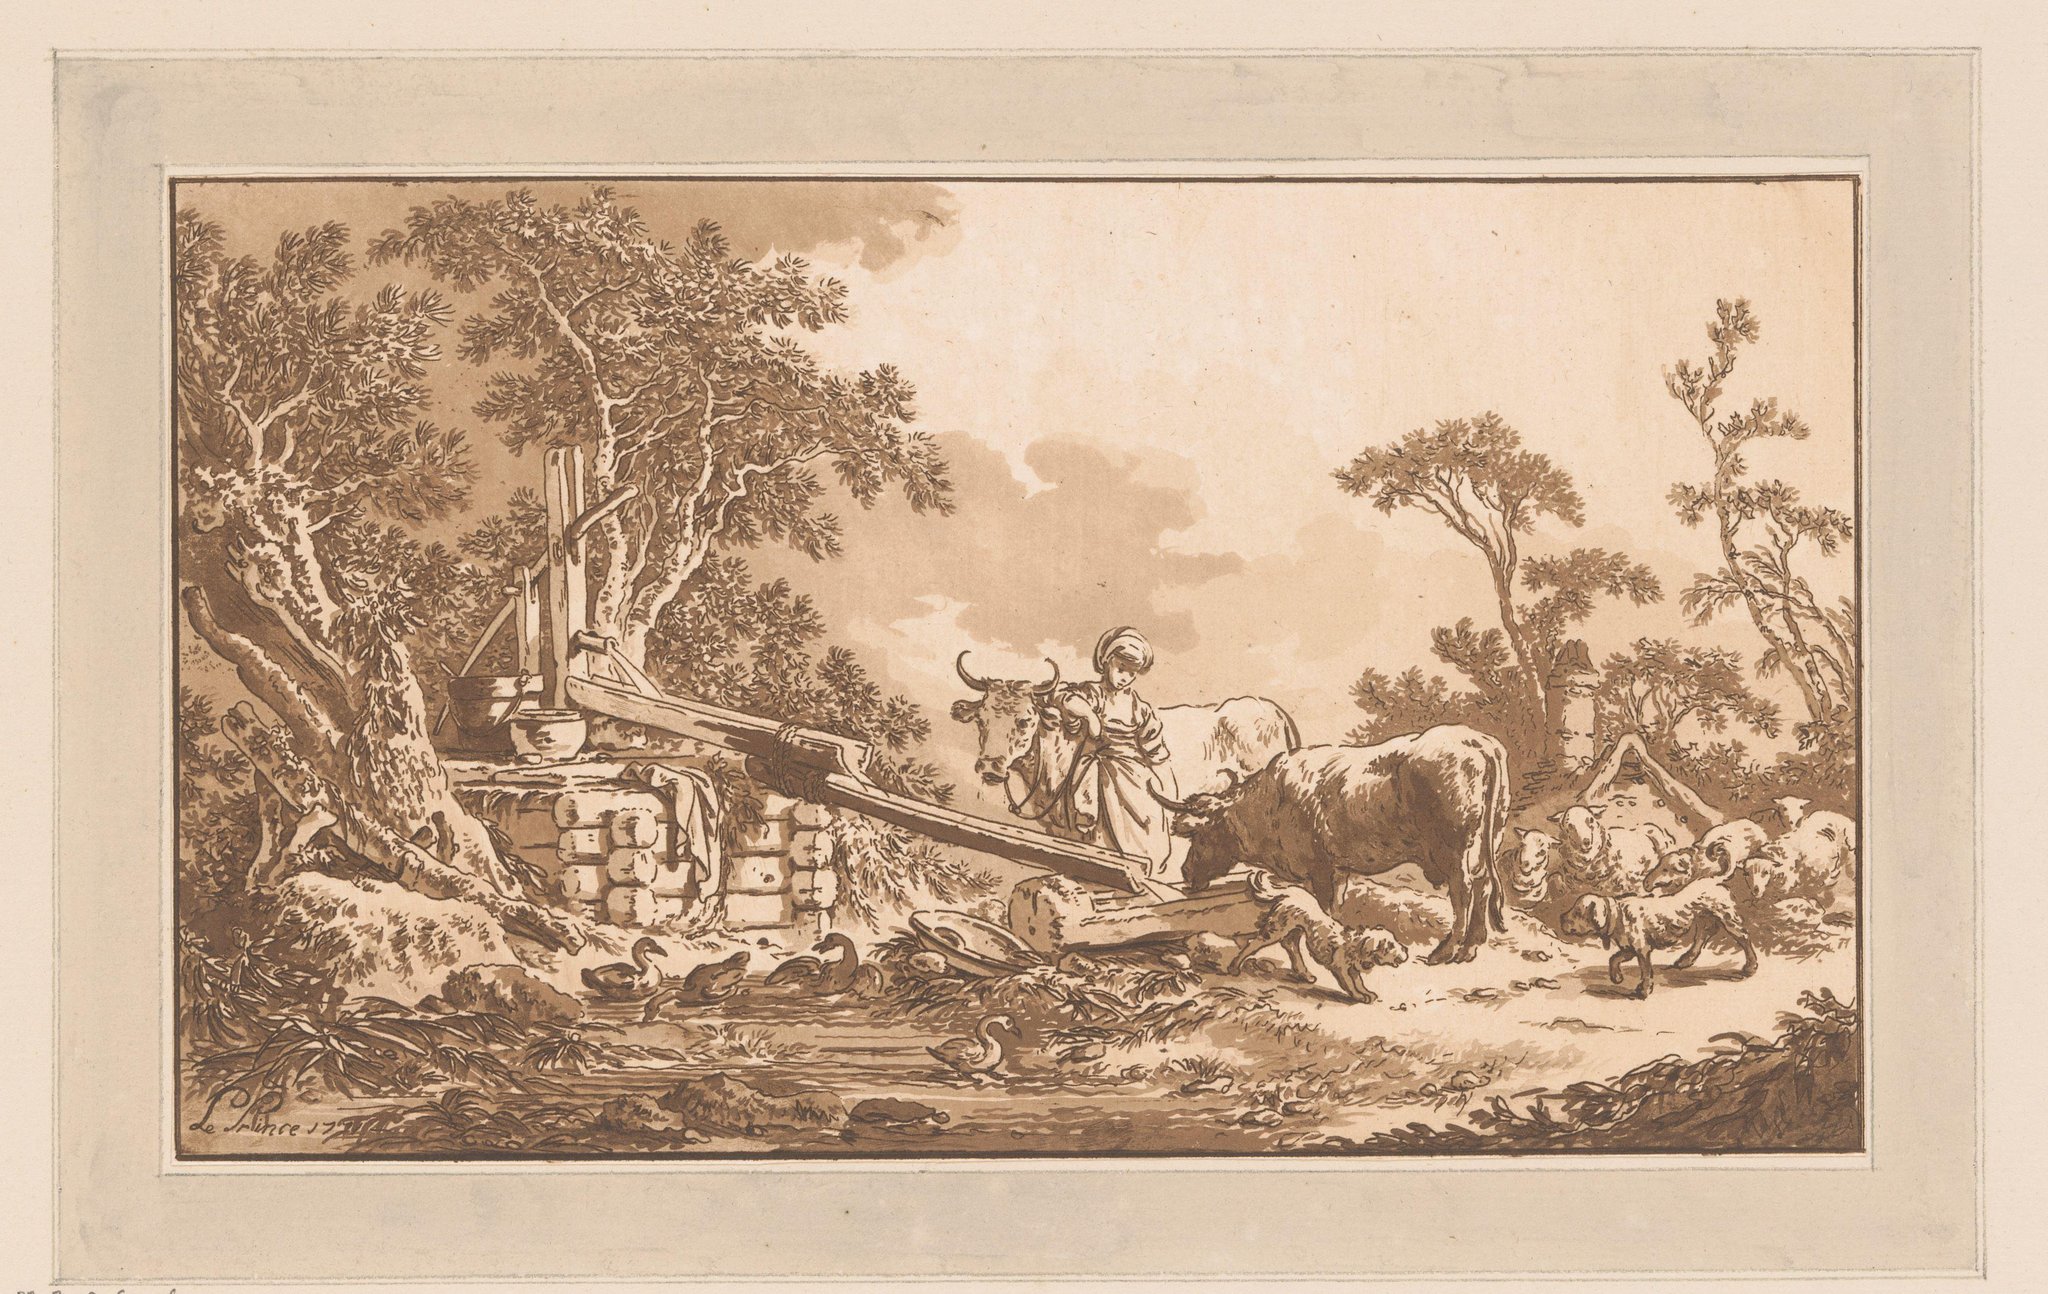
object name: print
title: Herderin geeft koeien te drinken bij een waterpomp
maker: jean baptist leprince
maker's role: draughtsman, print maker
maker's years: 1734-1781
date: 1771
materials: paper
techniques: aquatint, etching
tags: herding, herdsman, herdswoman, shepherd, shepherdess, cowherd, etc., giving water, feeding (cattle), utilitarian, public pump or water fountain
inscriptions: date